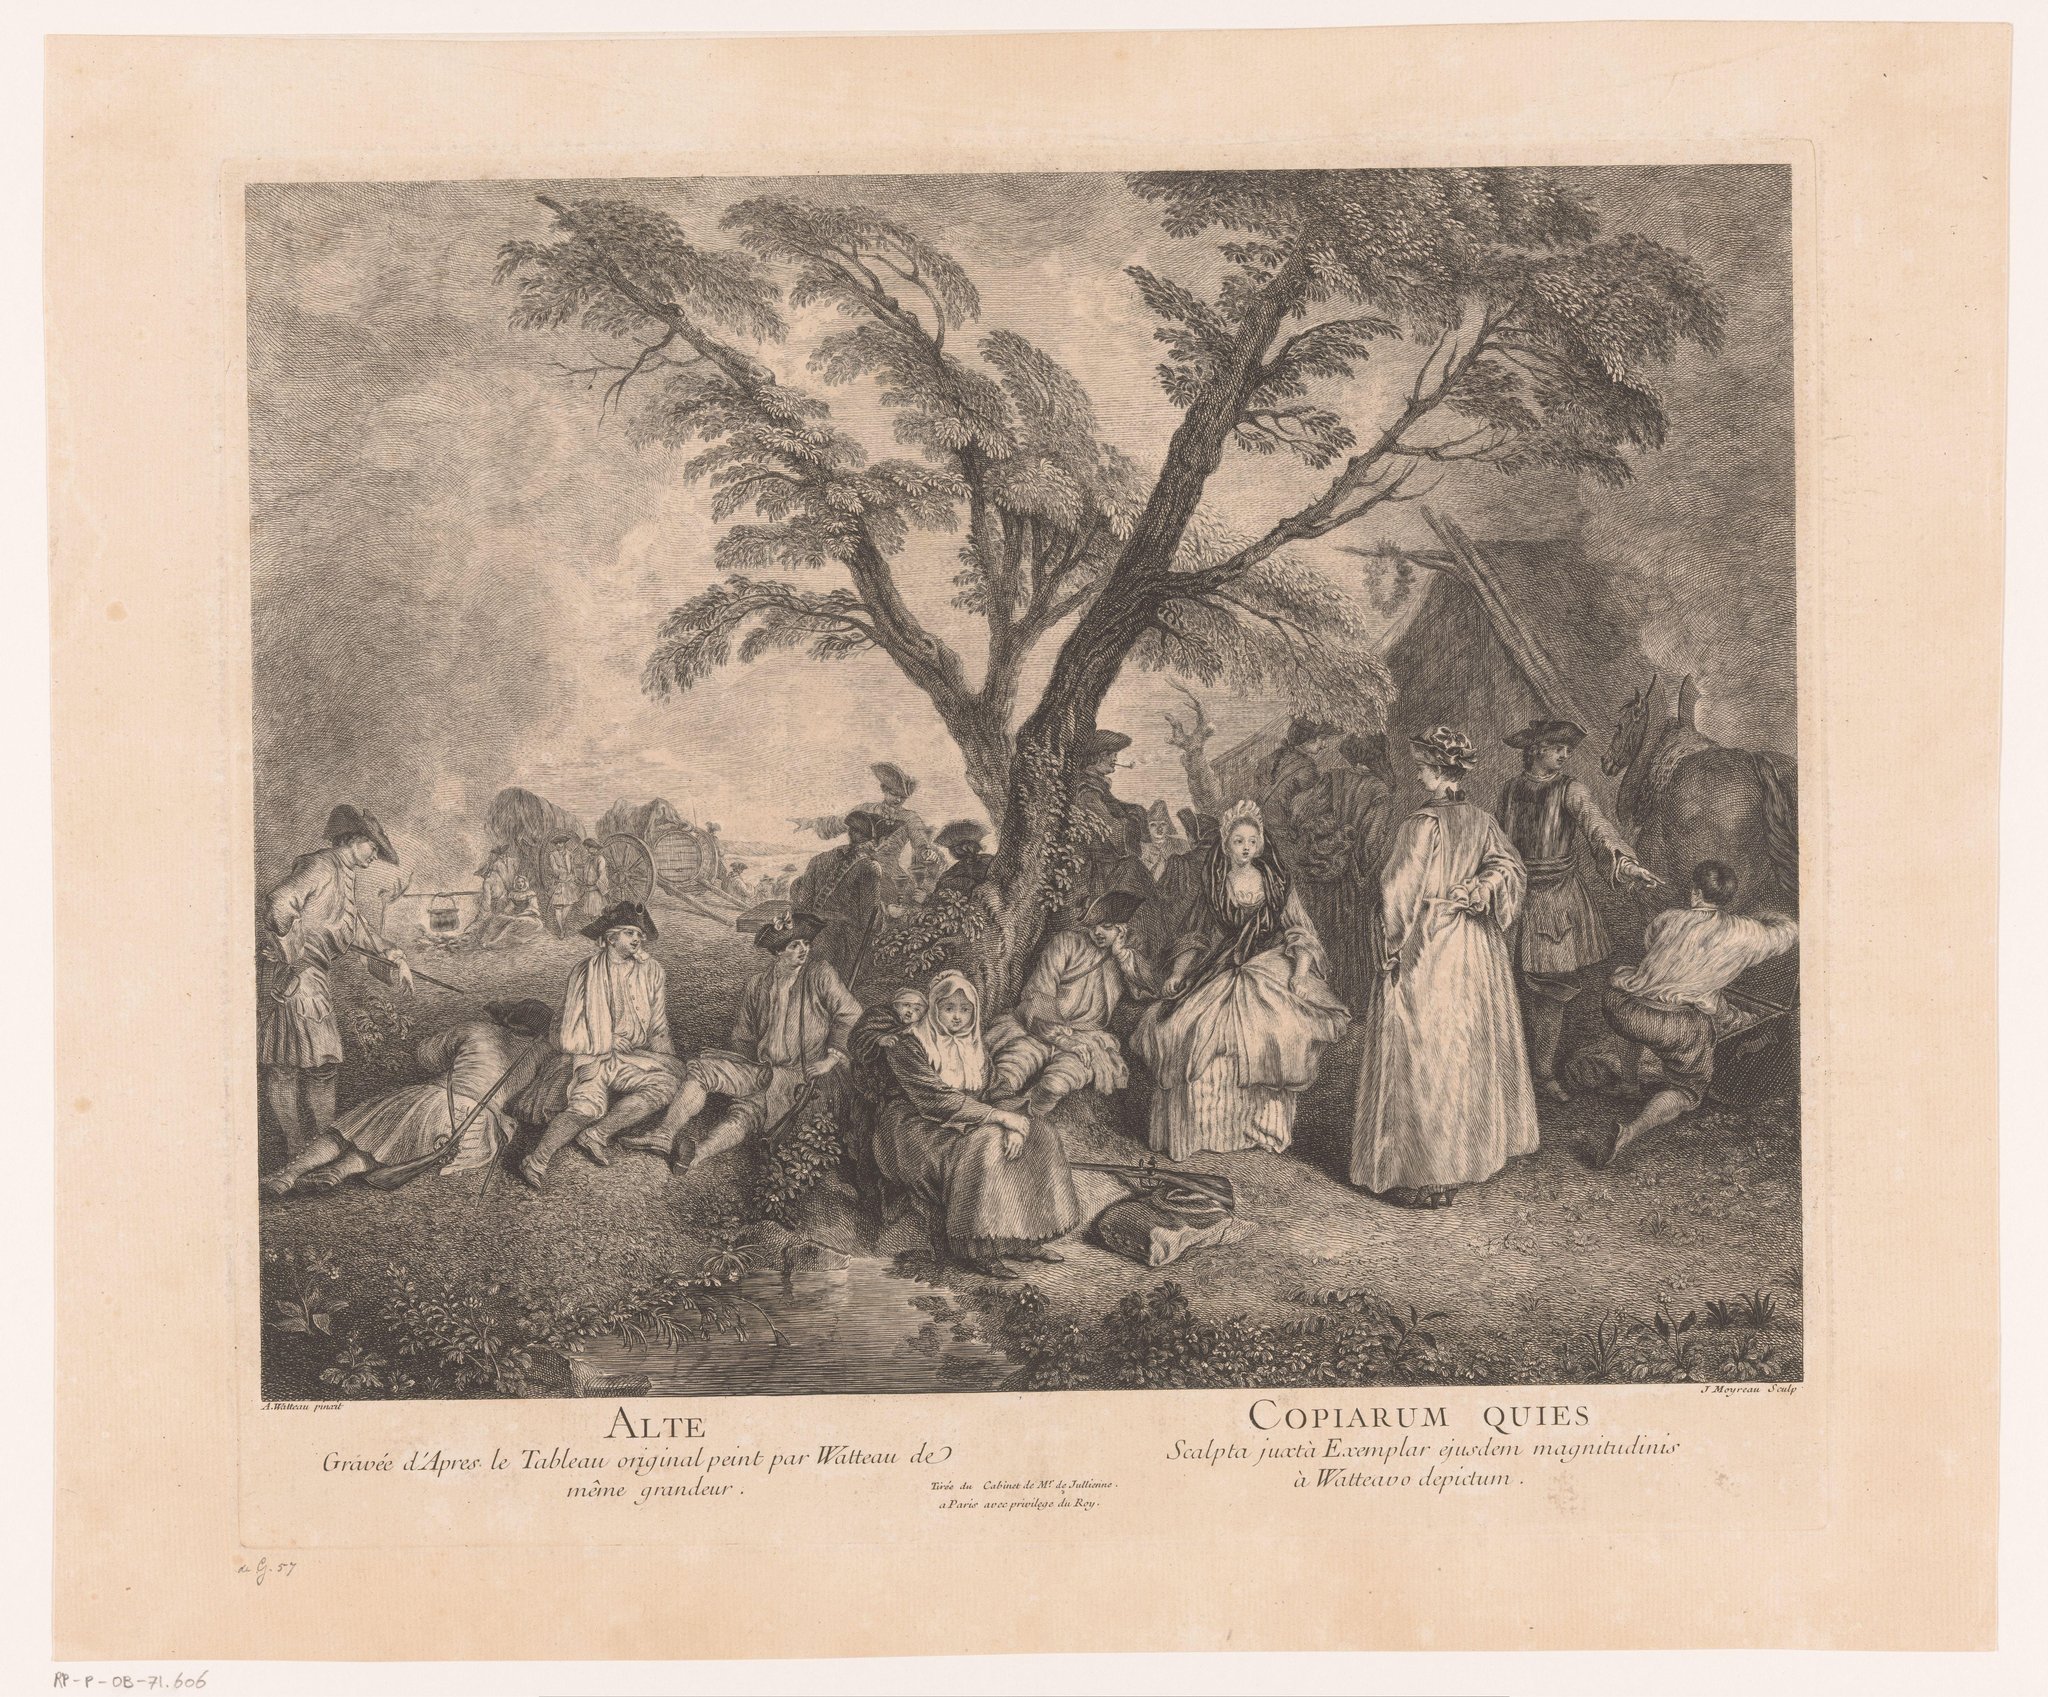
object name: print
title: L'oeuvre d'Antoine Watteau, peintre du roy en son Academie roïale de peinture et sculpture (...)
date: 1726-1735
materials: paper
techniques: engraving, etching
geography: france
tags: disabled soldier, return of the soldiers to civilian life, returning home, the soldier off duty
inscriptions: collector's mark: Lugt 2228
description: Maakt deel uit van een serie van 271 platen naar schilderijen door Watteau, verdeeld over drie delen, gecoördineerd door Jean de Jullienne en uitgegeven in Parijs tussen 1726 en 1735. Sommige platen werden reeds tijdens Watteau's leven gemaakt. Dit betreft plaat 224.